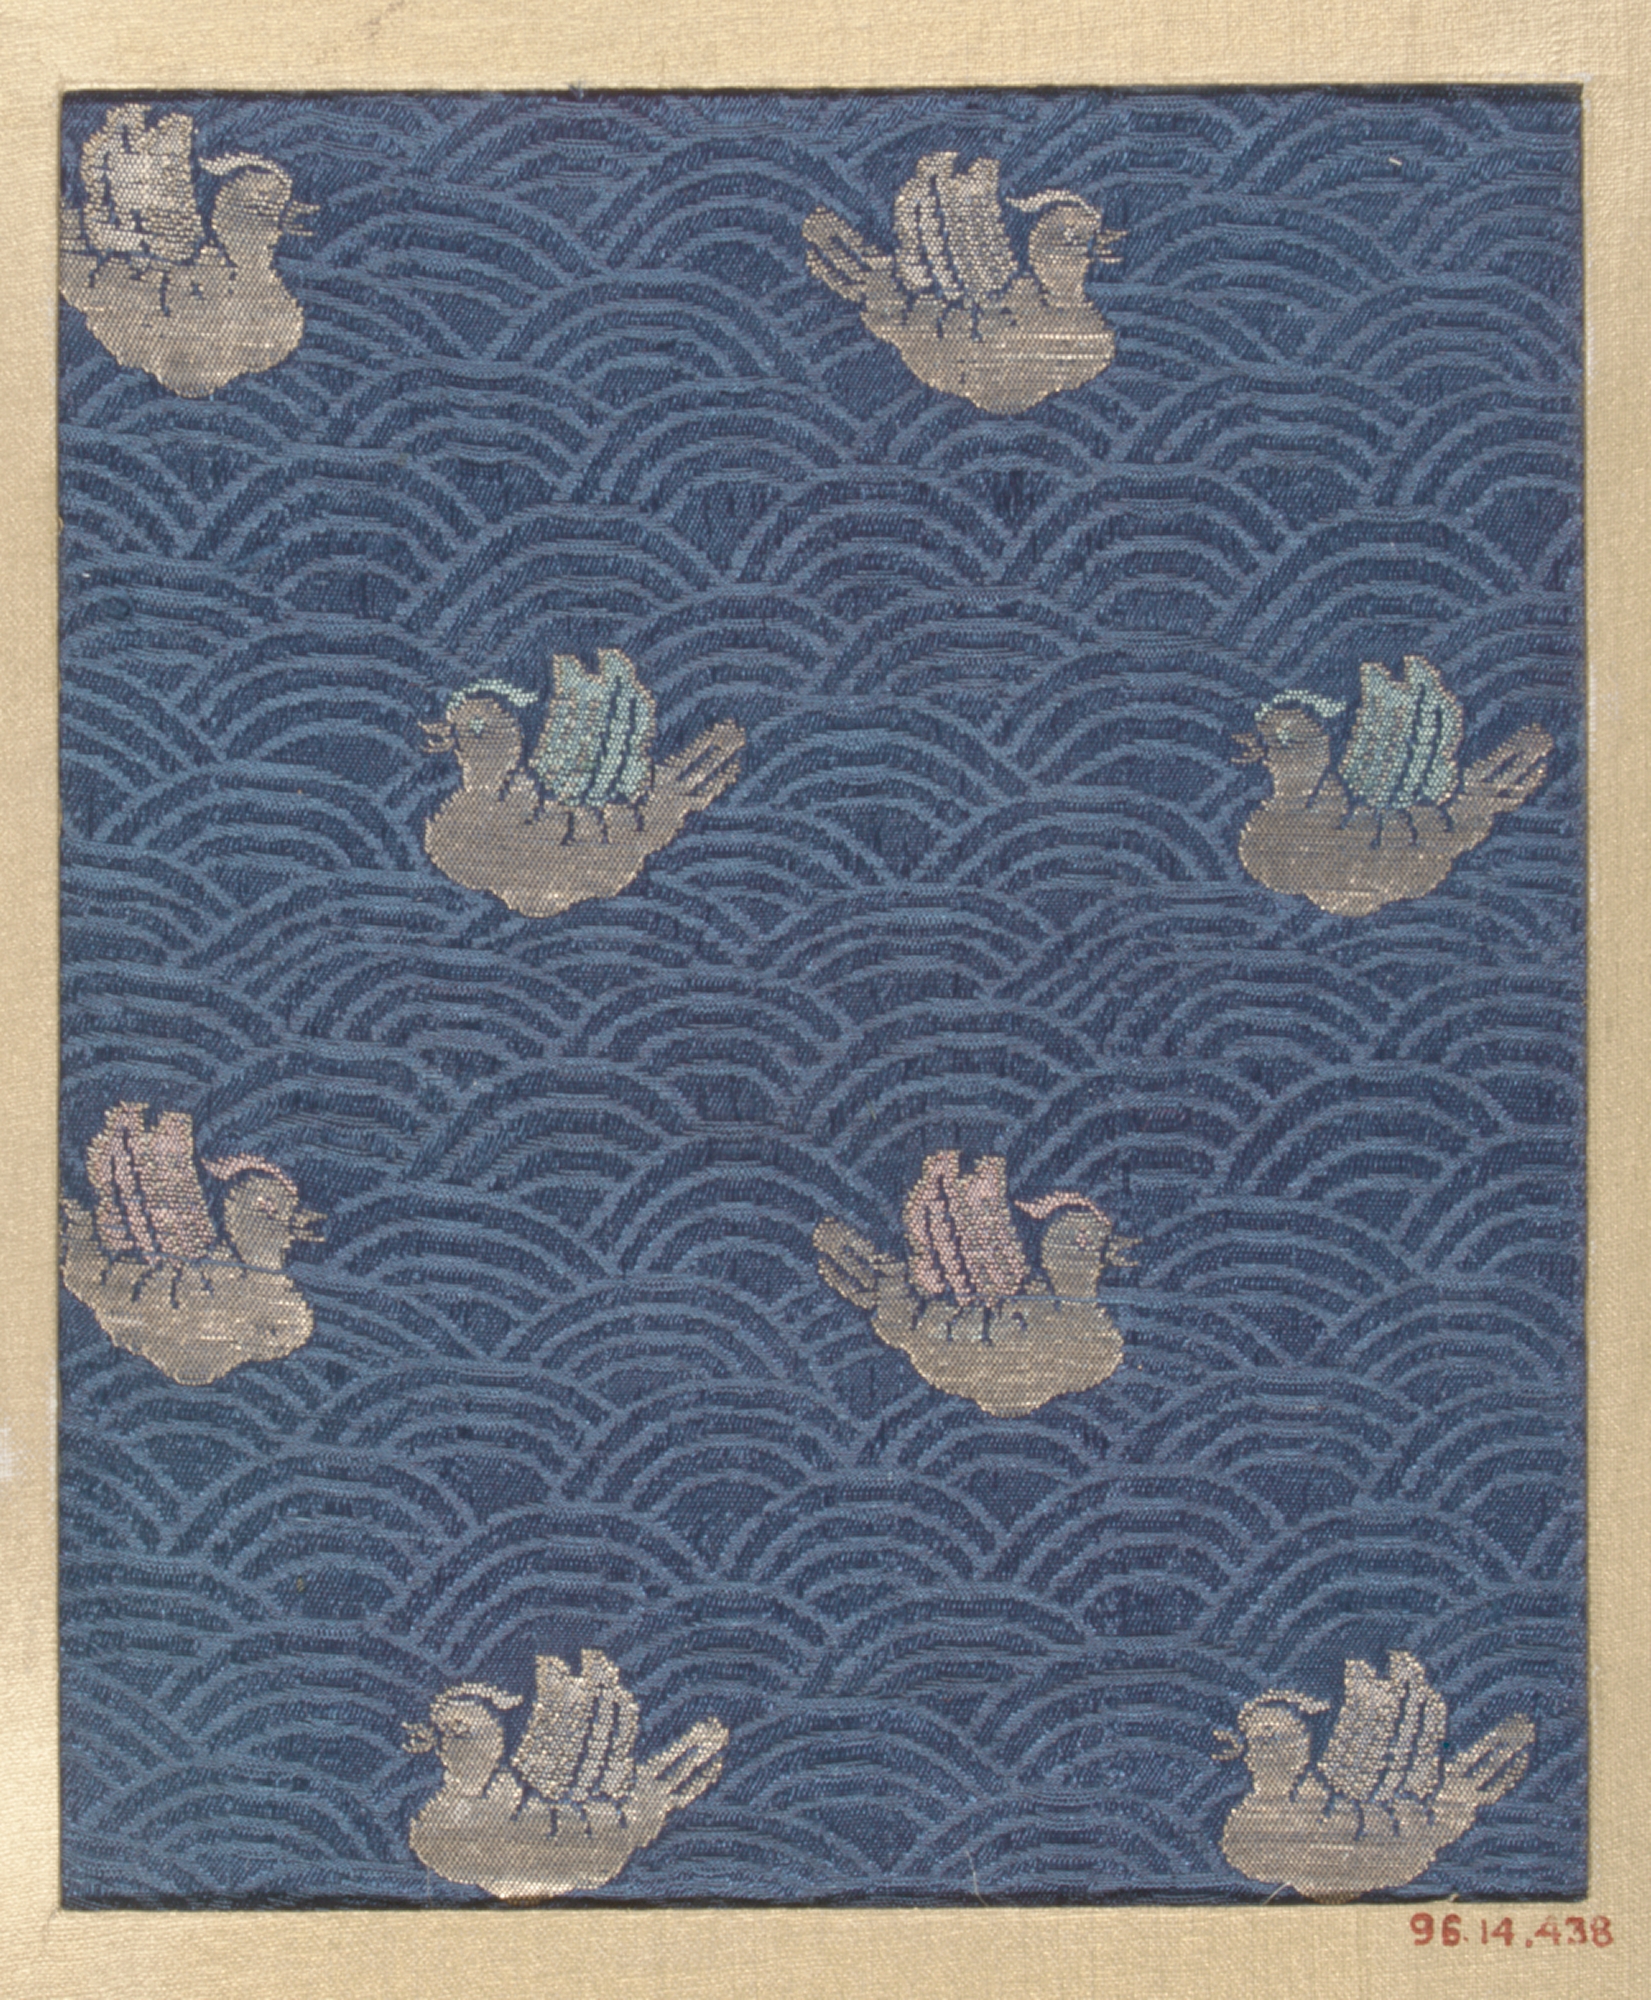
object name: piece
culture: japanese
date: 1701-1900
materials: silk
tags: ducks